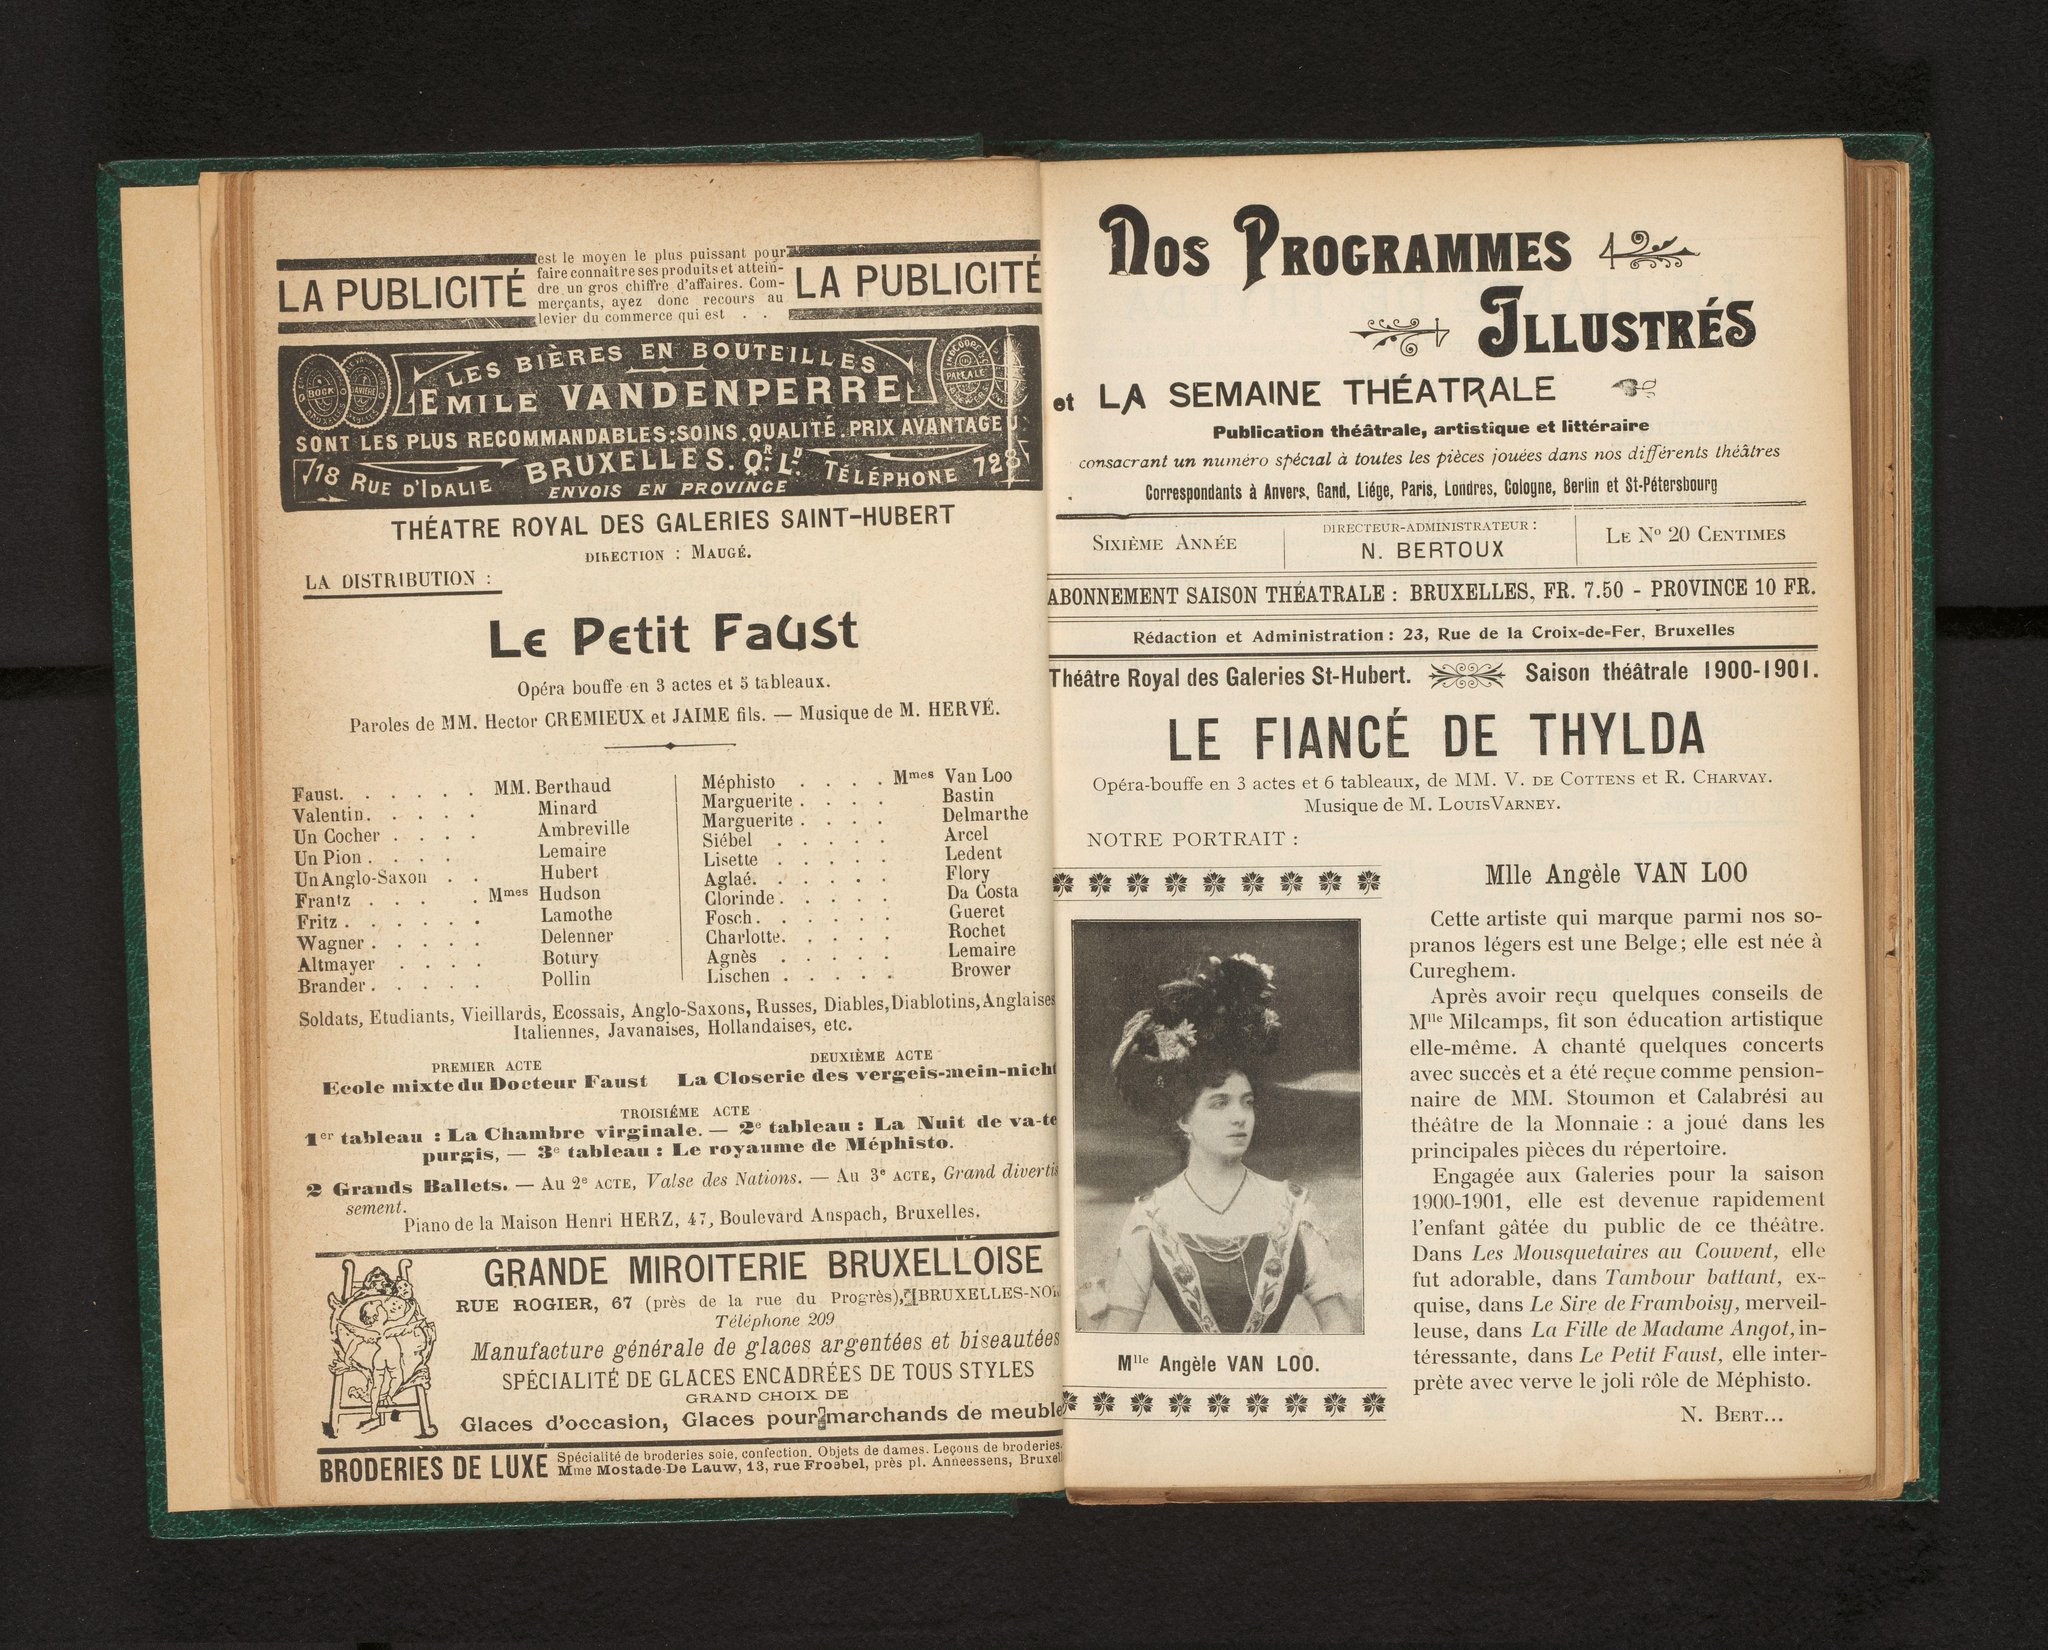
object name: photomechanical print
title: Portret van Angèle van Loo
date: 1895-1900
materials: paper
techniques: autotype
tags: adult woman, historical persons